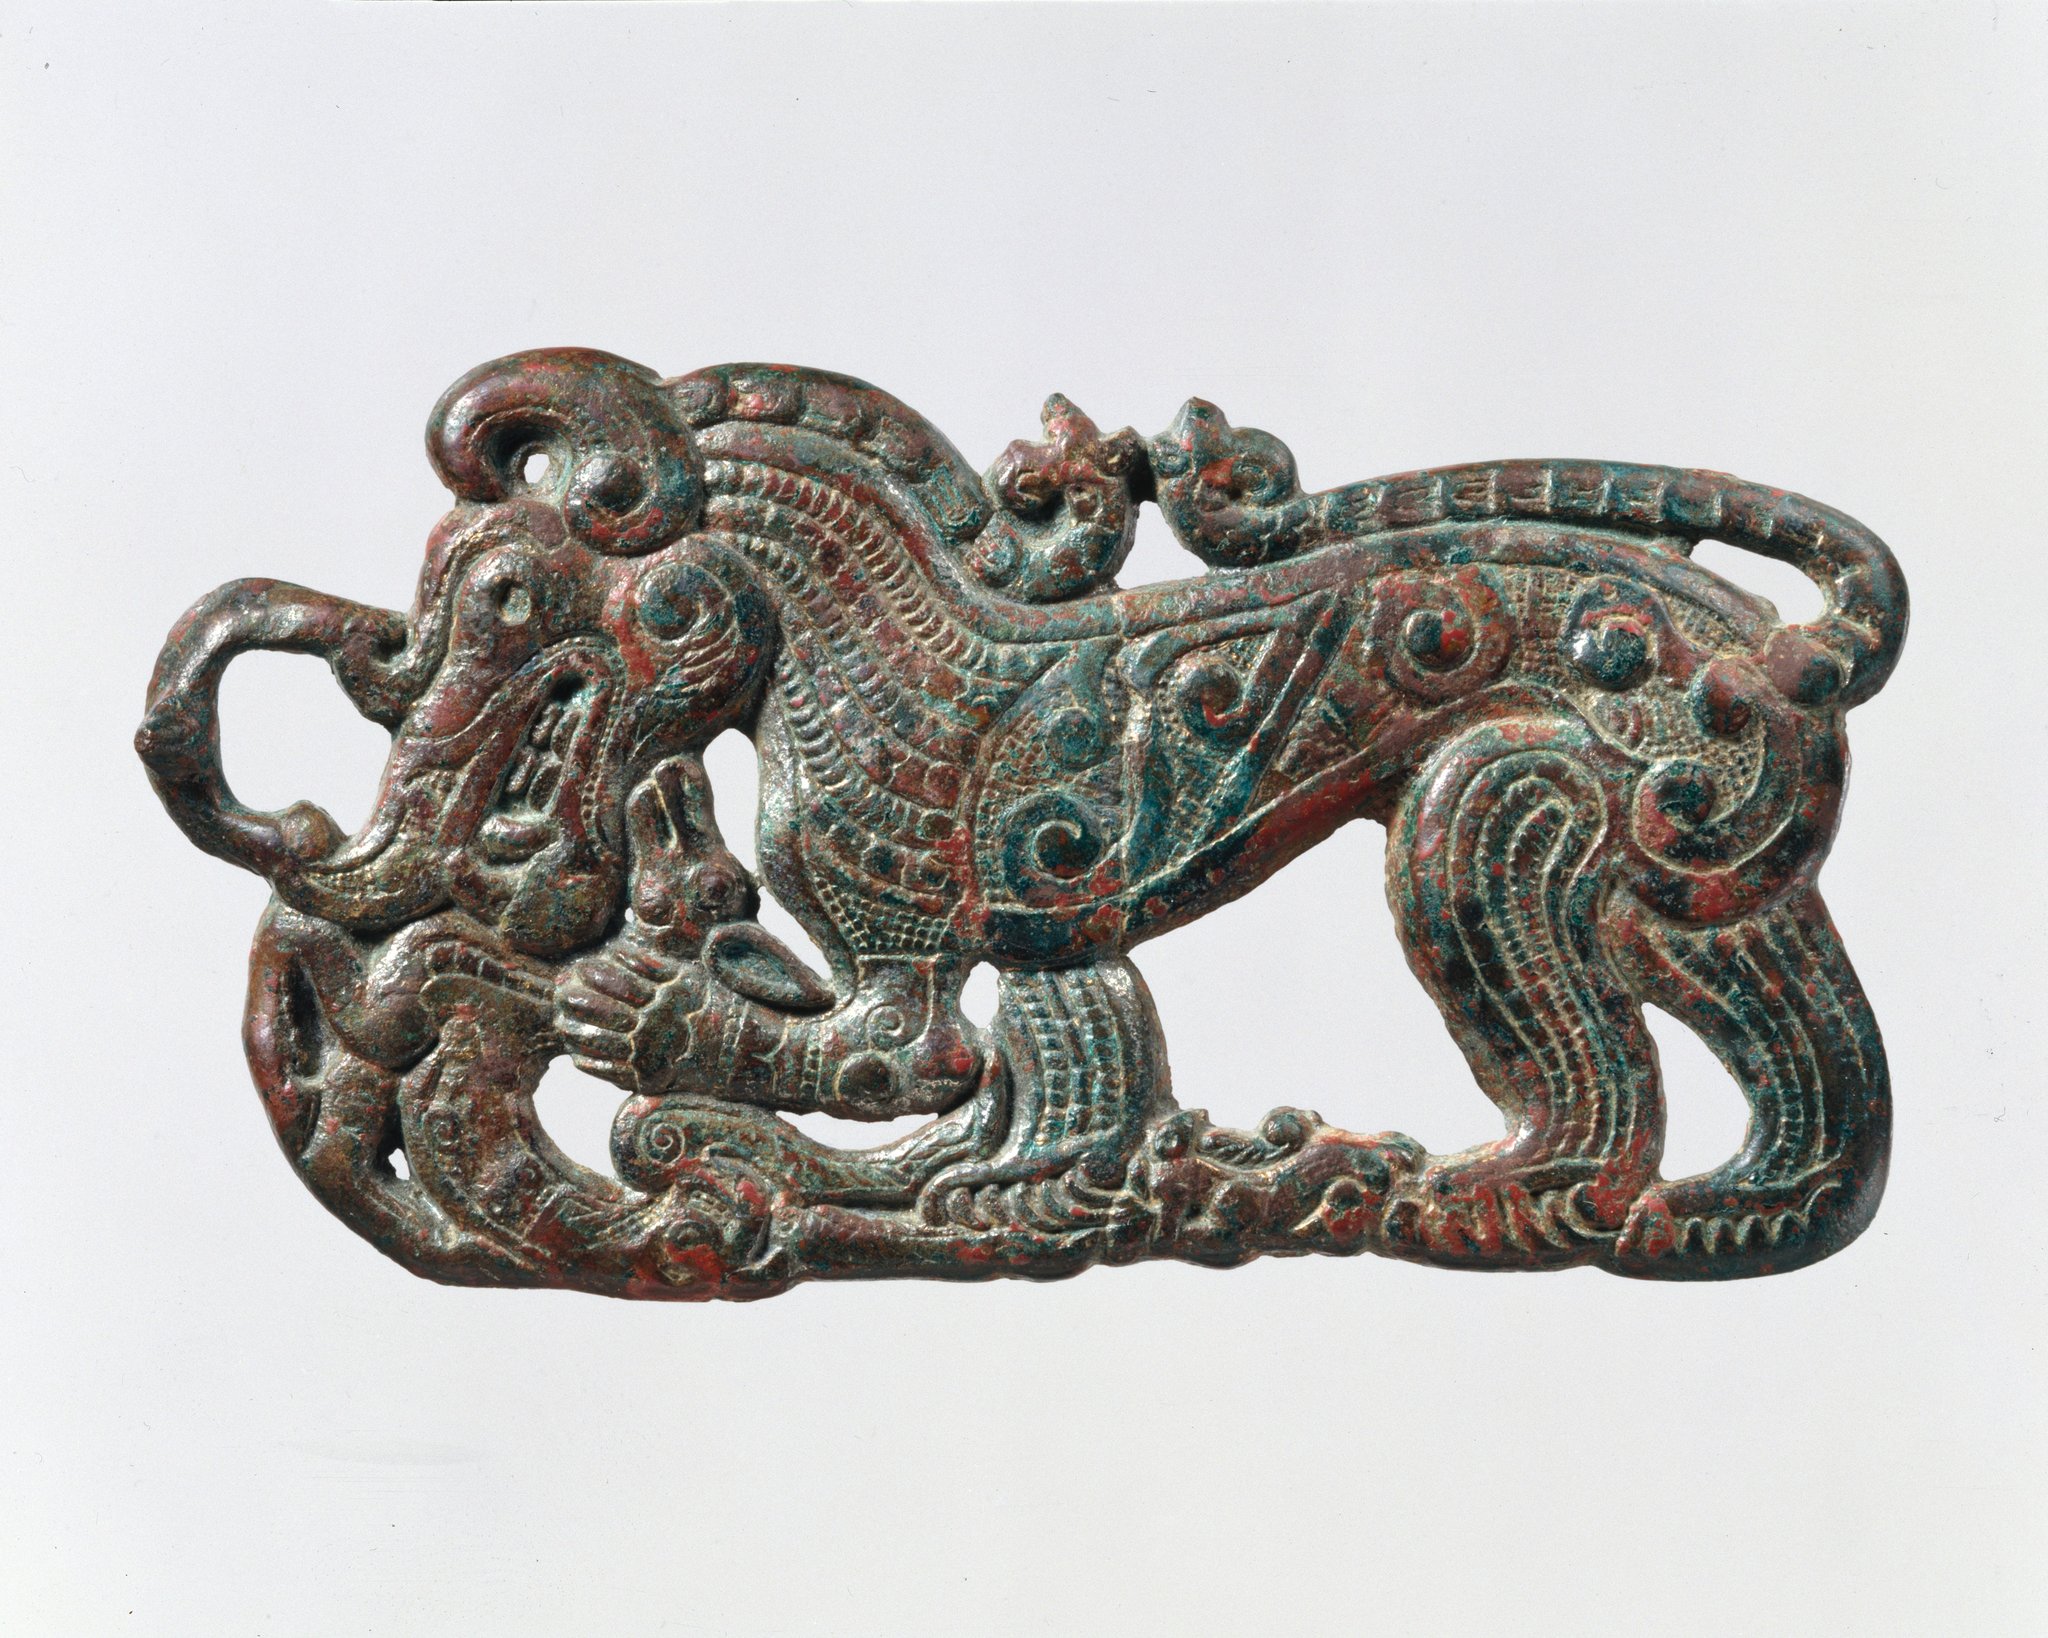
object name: belt plaque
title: Belt Plaque in the Shape of a Standing Wolf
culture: northwest chinese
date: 400-301 BCE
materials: bronze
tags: animals